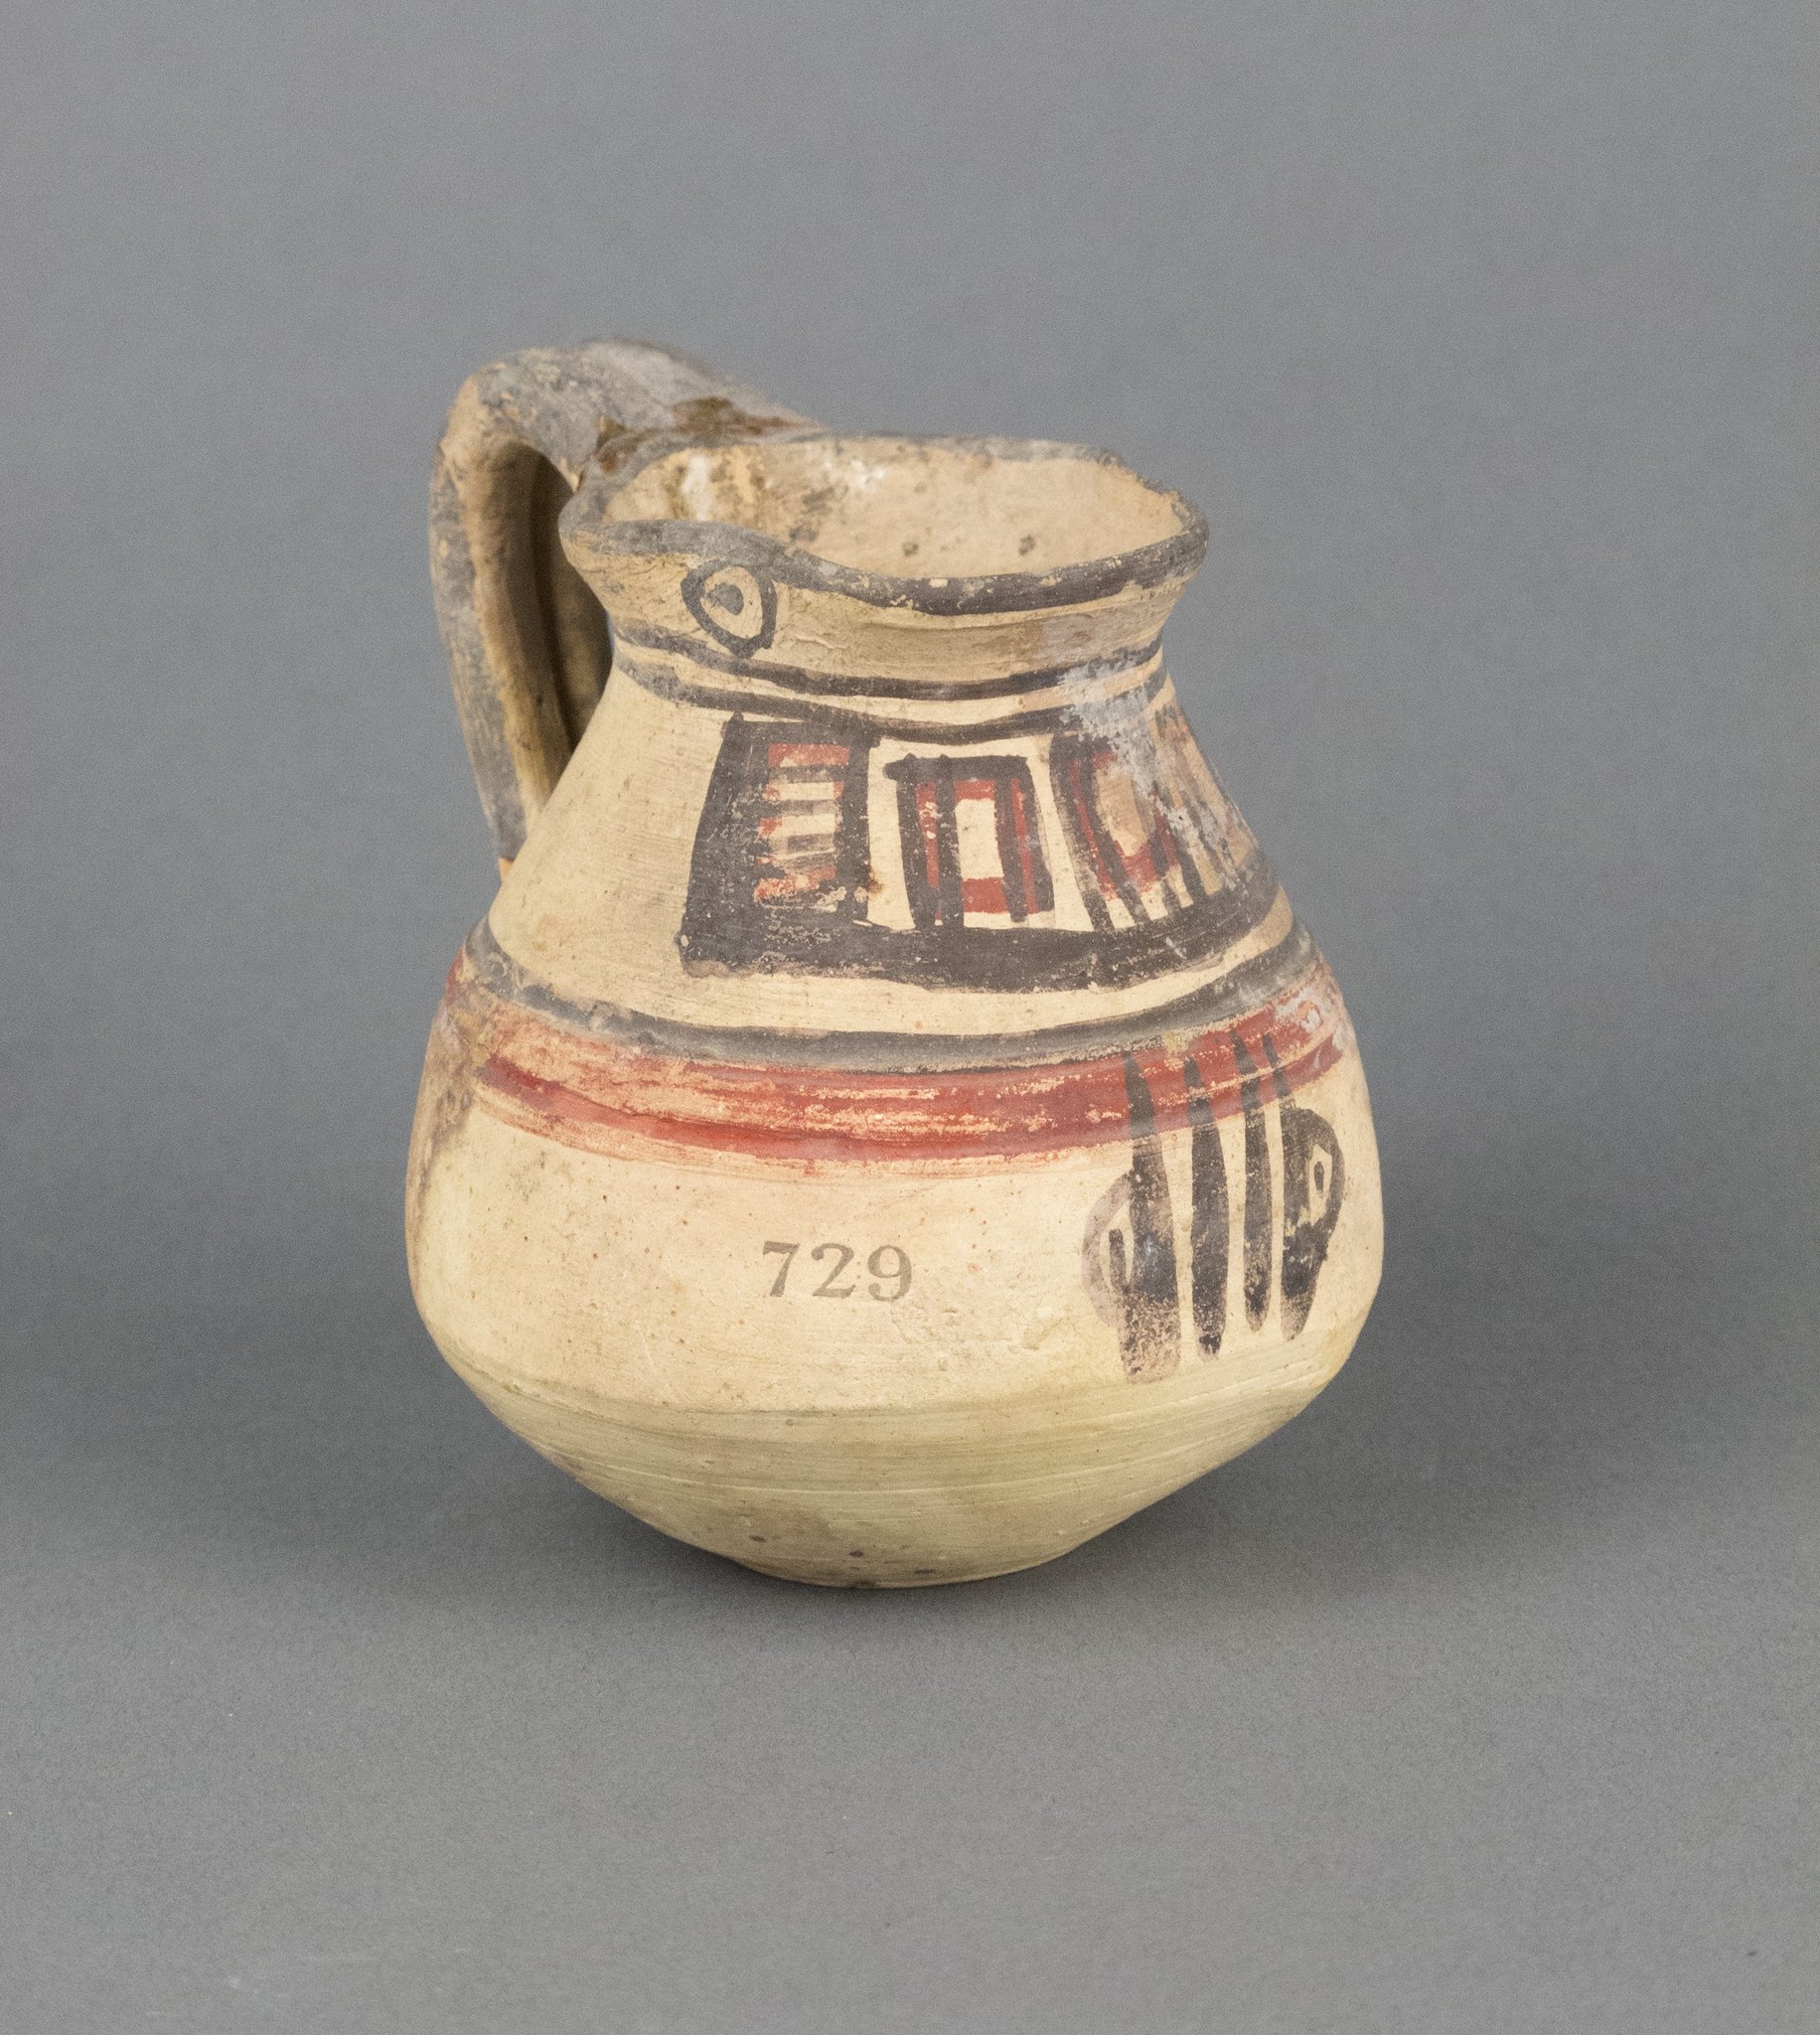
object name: juglet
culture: cypriot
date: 750-600 BCE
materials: terracotta